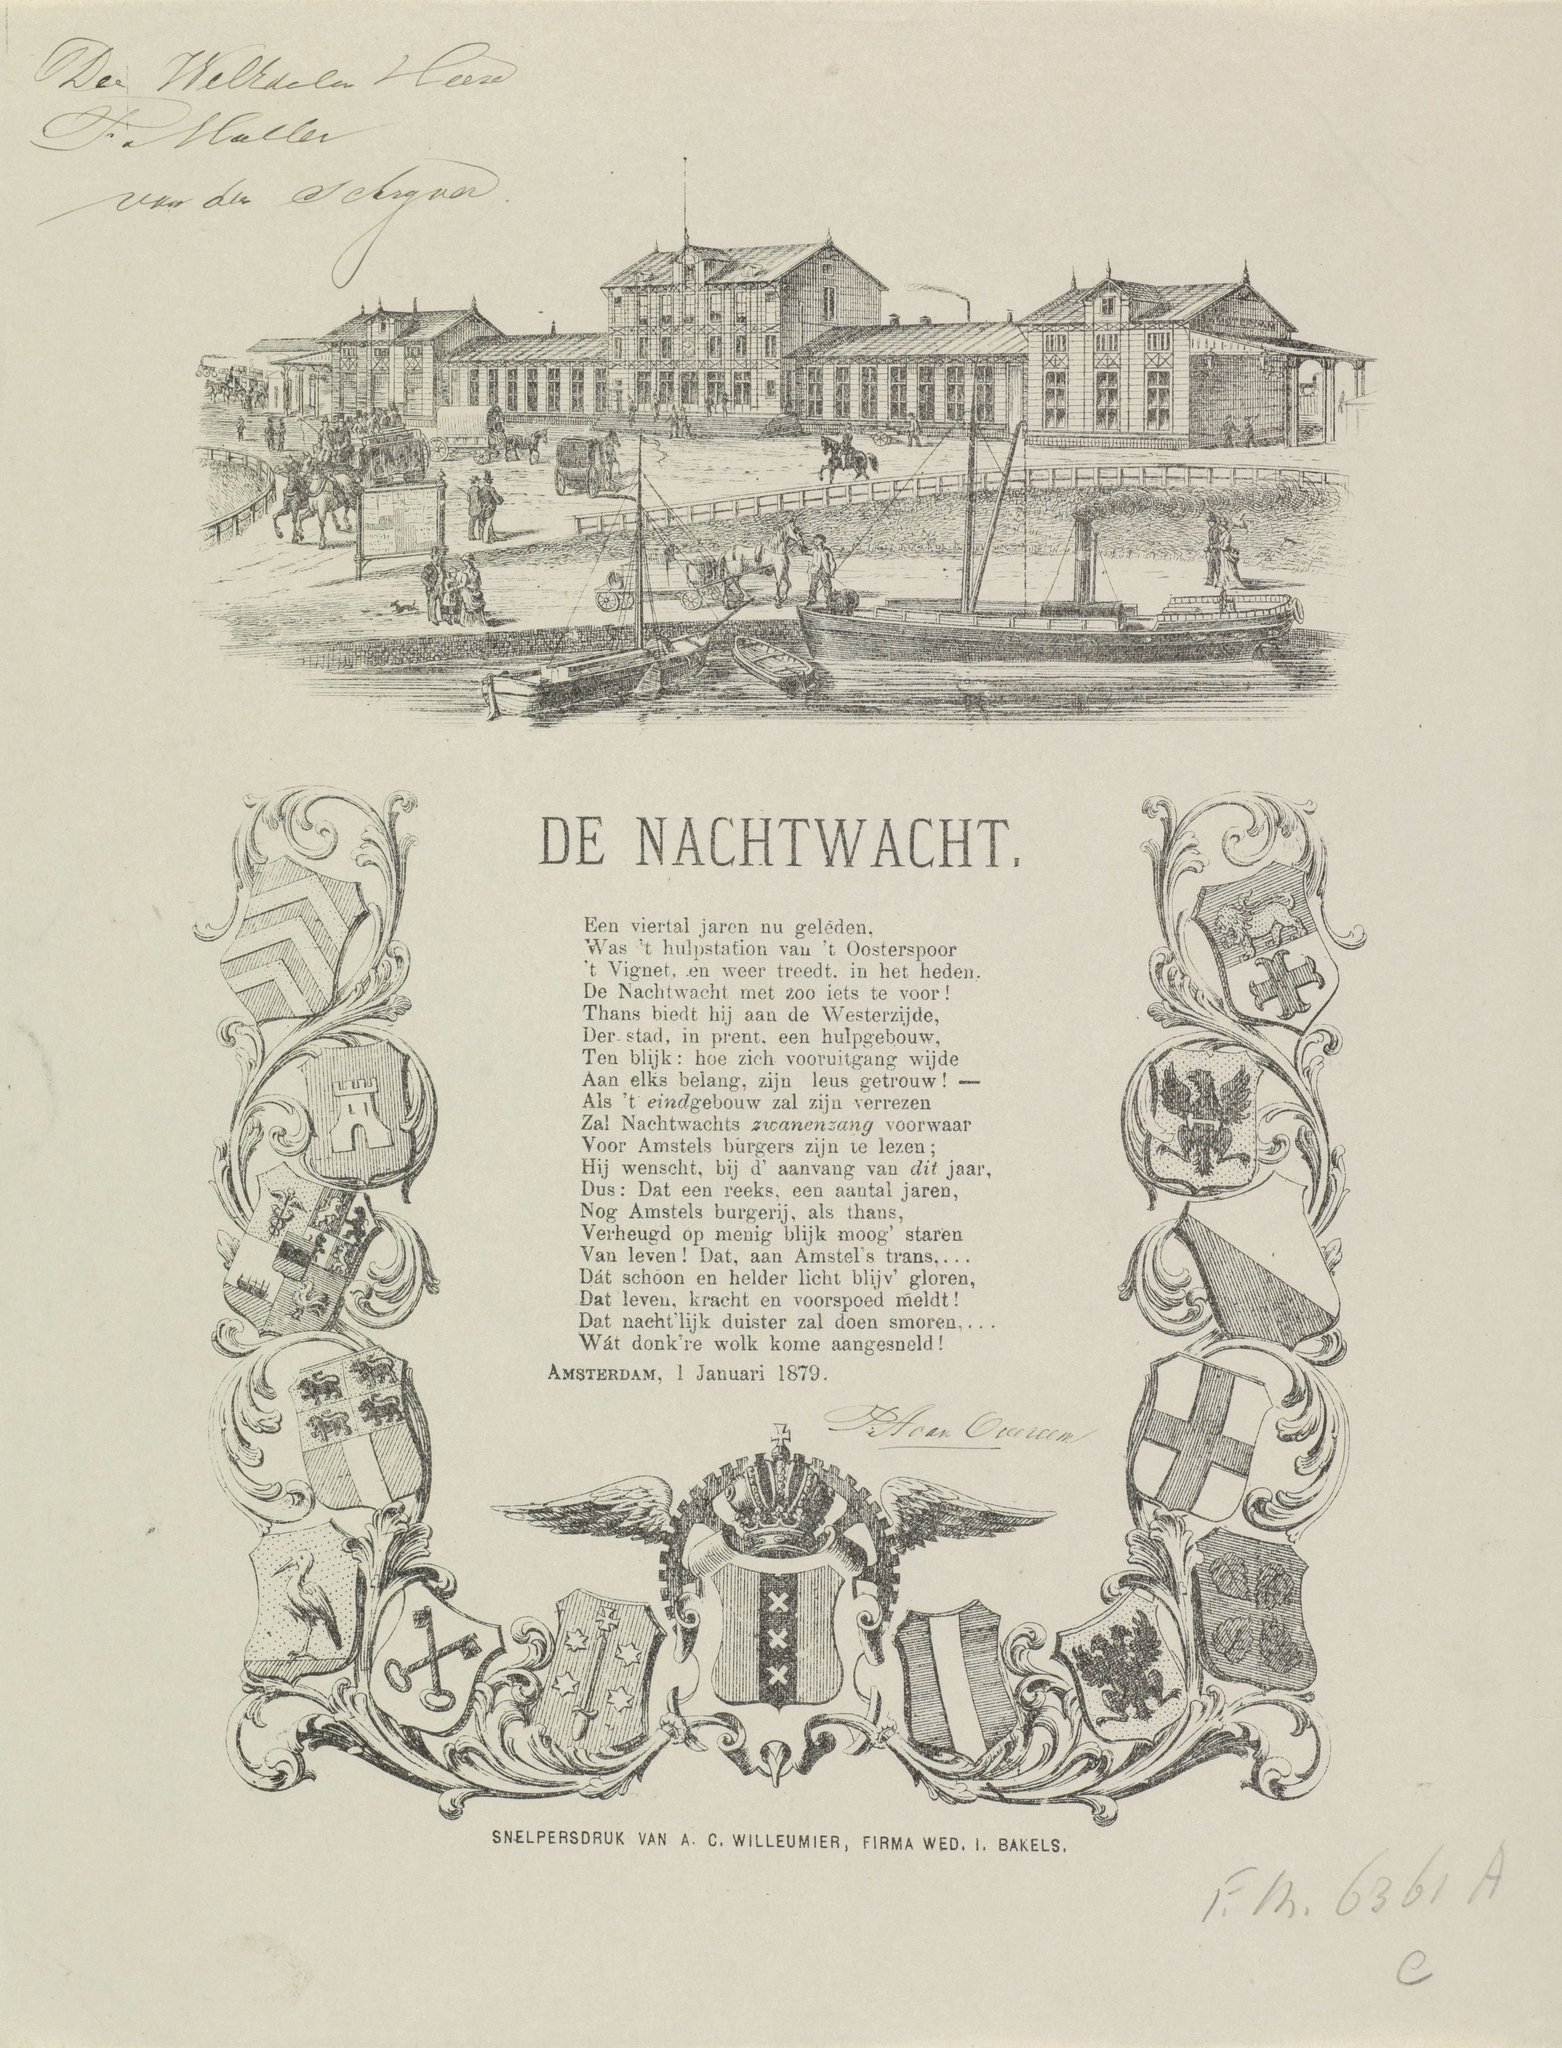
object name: print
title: De Nachtwacht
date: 1878-1879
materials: paper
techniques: lithograph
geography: netherlands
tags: night patrol, station; shelter (railway, tramway), amsterdam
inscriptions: inscription: ‘Den WelEdelen Heer F Muller / van den schrijver’, signature: ‘PA van Overeem’, collector's mark: Lugt 2228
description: Nieuwjaarswens van de Amsterdamse nachtwacht (ratelwacht) voor het jaar 1879. Centraal een gedicht, bovenaan een gezicht op het hulpstation Westerdok van het Oosterspoor van de Hollandsche IJzeren Spoorweg-Maatschappij op de Droogbak. Om het gedicht wapens.